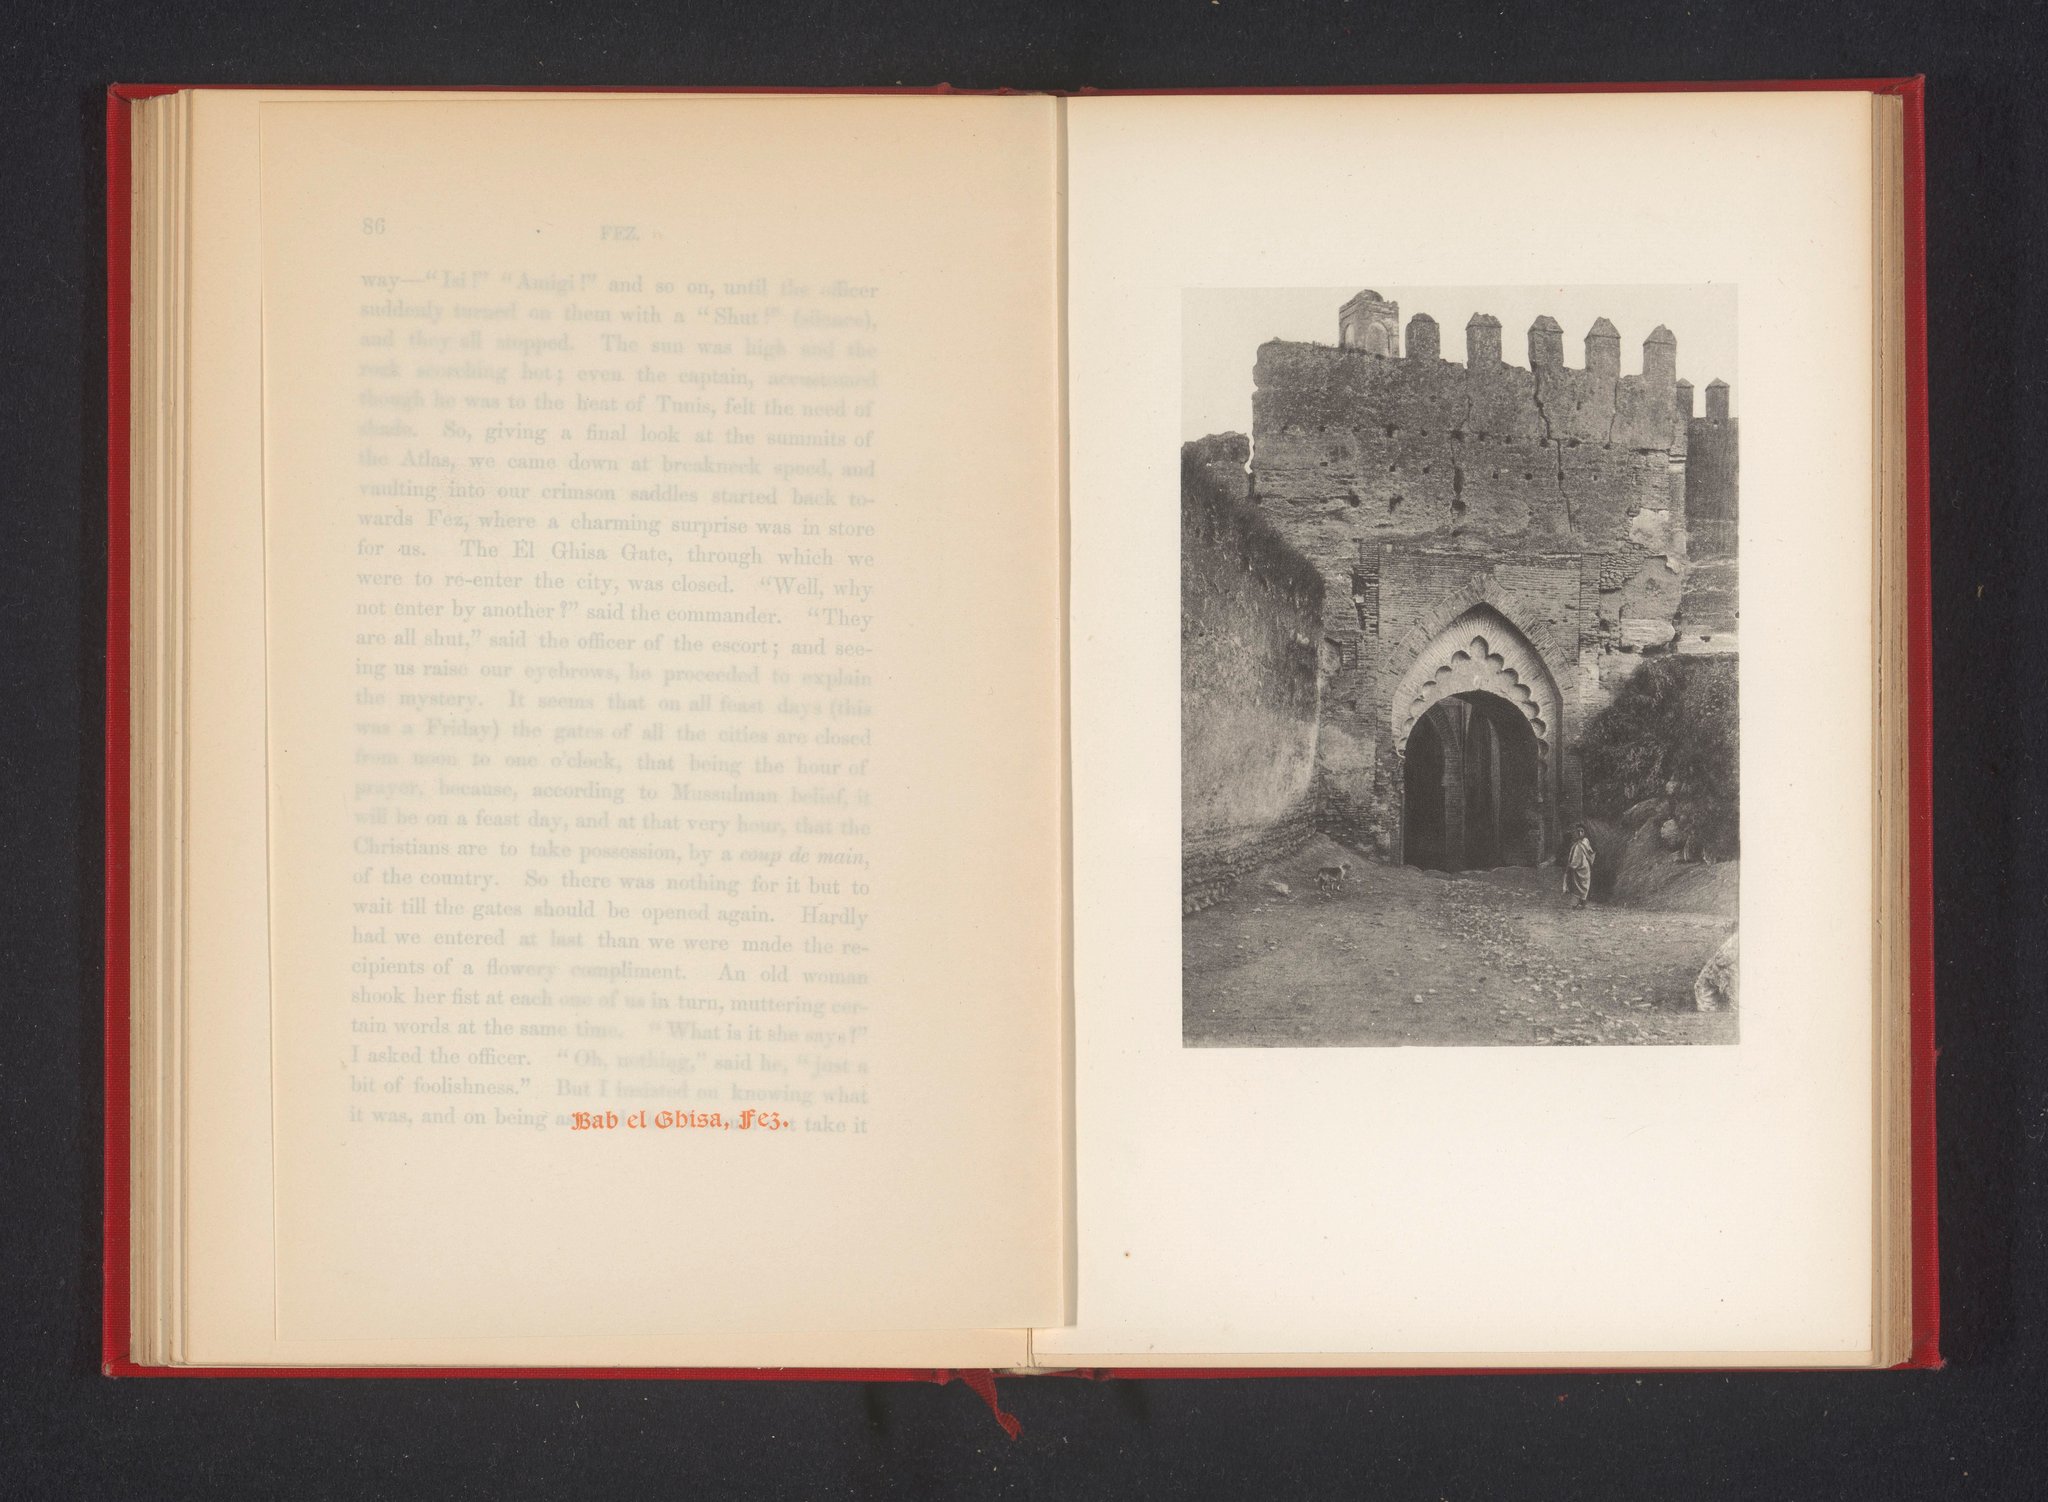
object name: photomechanical print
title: Gezicht op een poort te Fez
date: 1887-1897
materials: paper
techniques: photoaquatint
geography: fez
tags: city-gate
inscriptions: title: ‘Bab el Ghisa, Fez.’